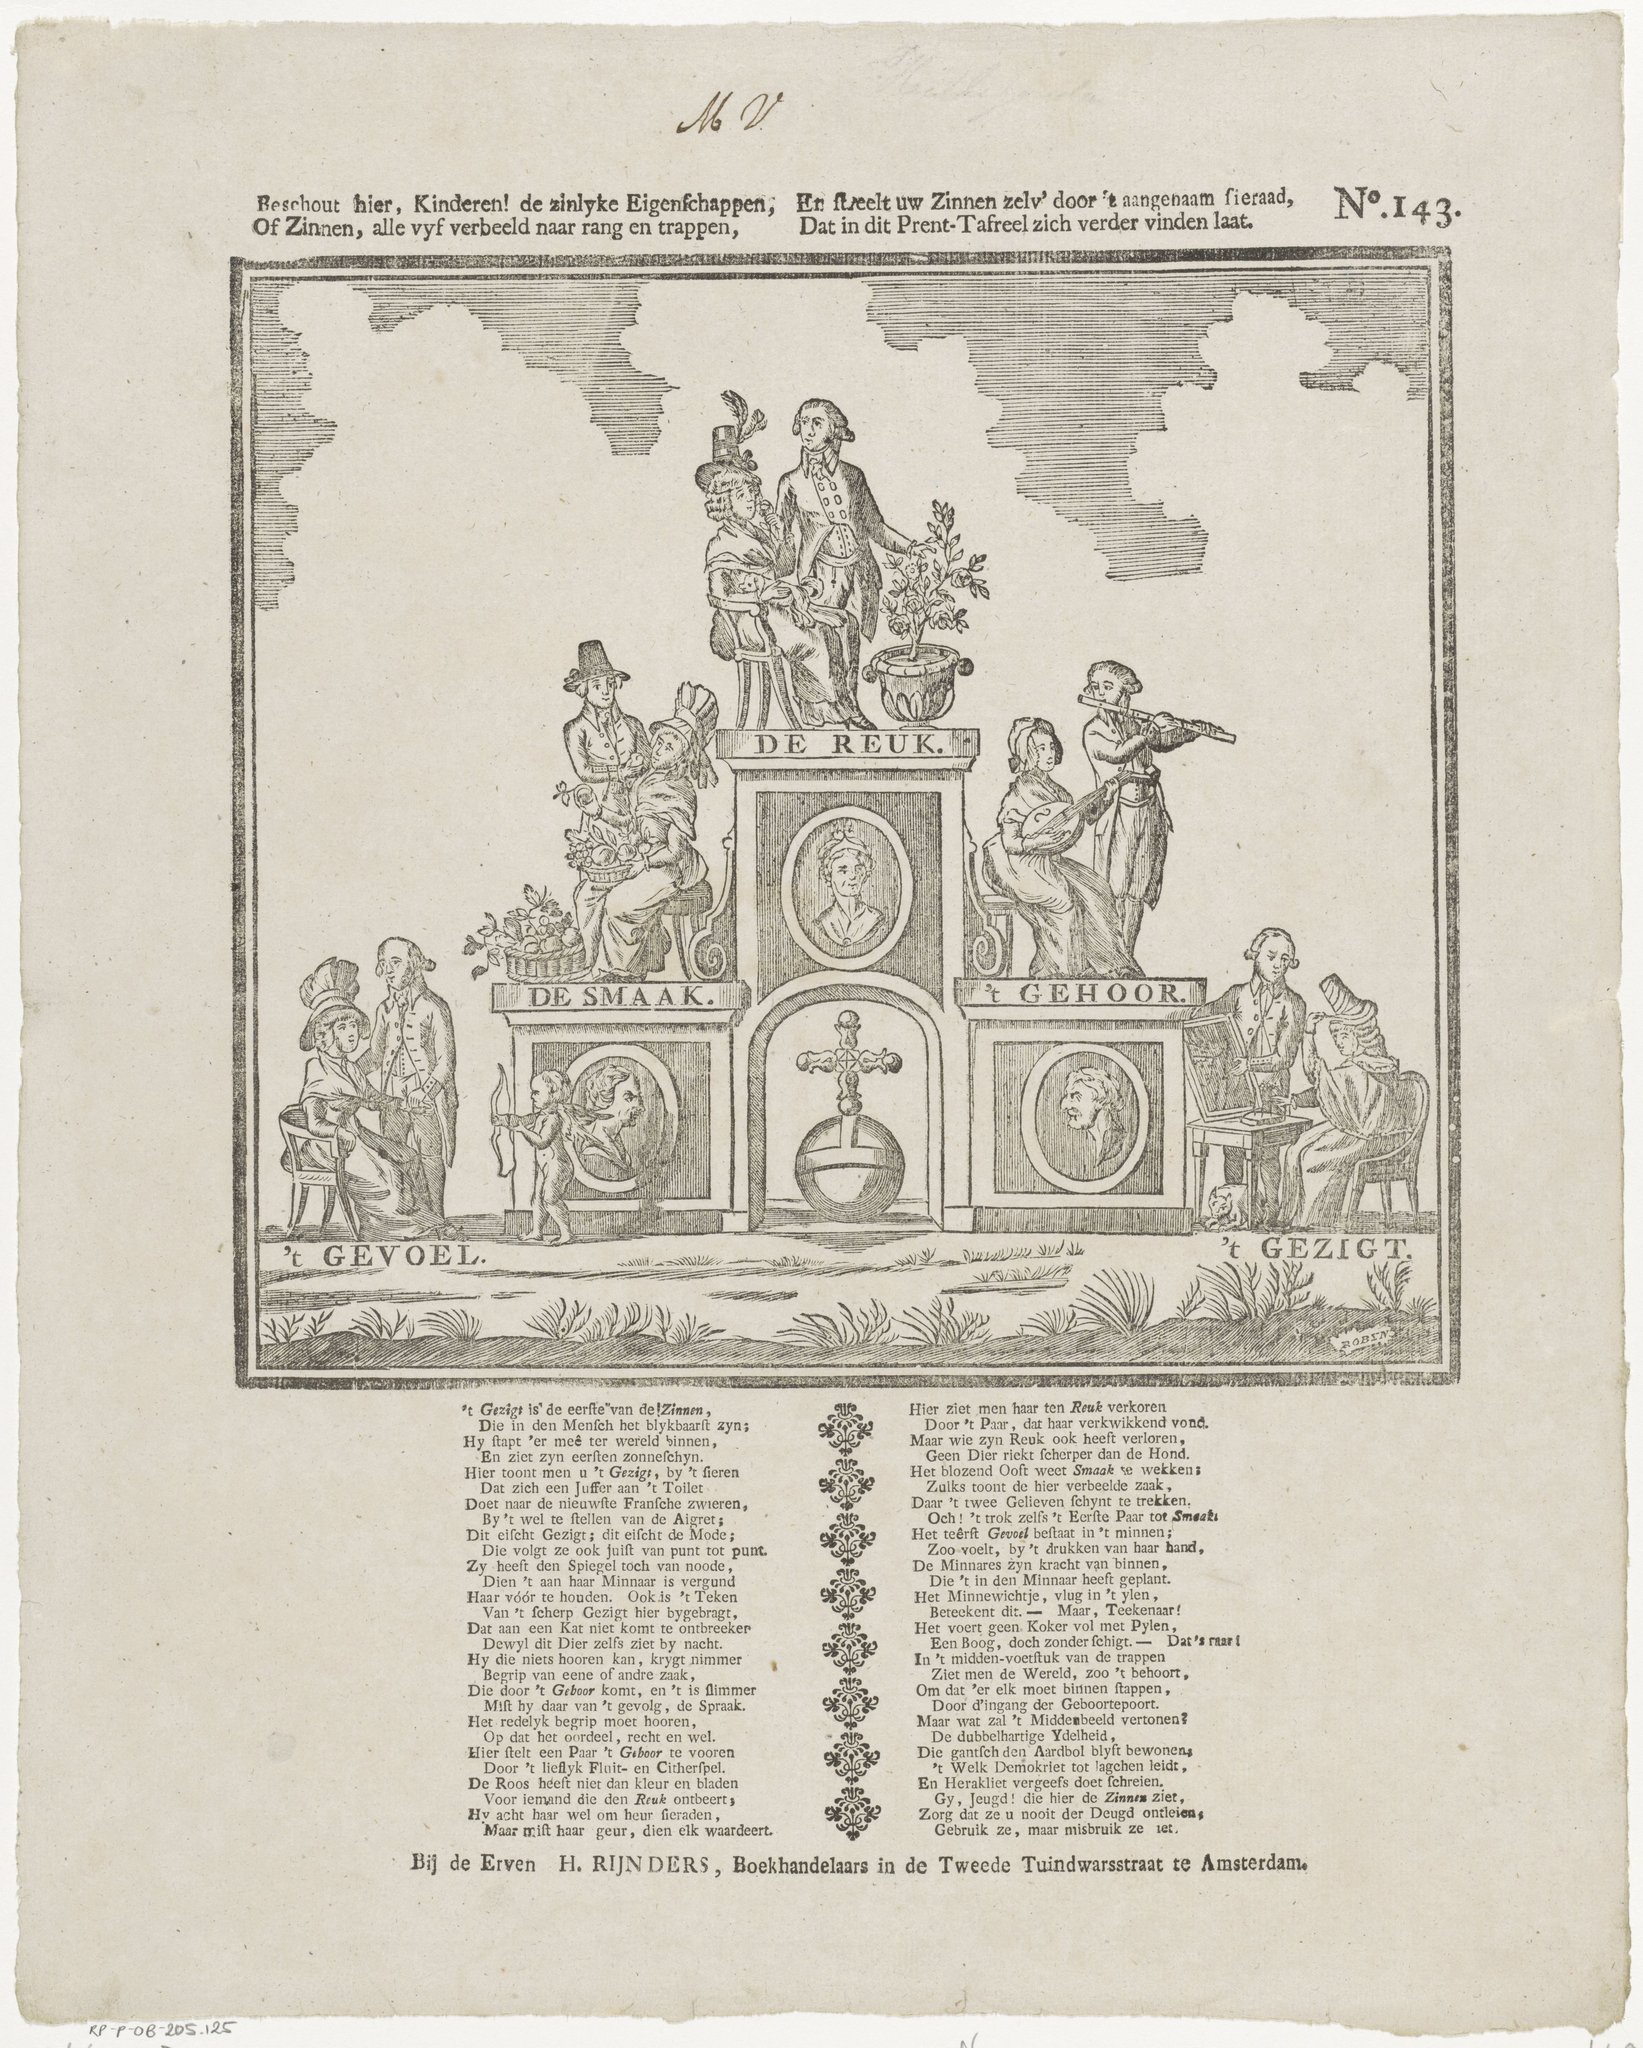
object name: print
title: Beschouwt hier, kinderen! de zinlyke eigenschappen, / of zinnen, alle vyf verbeeld naar rang en trappen, / En streelt uw zinnen zelv' door 't aangenaam sieraad, / Dat in dit prent-tafreel zich verder vinden laat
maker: johan noman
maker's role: printer, publisher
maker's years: -1833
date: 1831-1854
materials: paper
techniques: letterpress printing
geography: amsterdam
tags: the (five) senses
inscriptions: collector's mark: Lugt 2760, inscription: ‘M V’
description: Trap met op elke trede een paar dat één van de vijf zintuigen verbeeld. Van links naar rechts: het gevoel, de smaak, de reuk, het gehoor en het gezicht. Op de trap ook drie medaillons met portretten. Onder de afbeelding een vers in twee kolommen. Genummerd rechtsboven: No. 143.